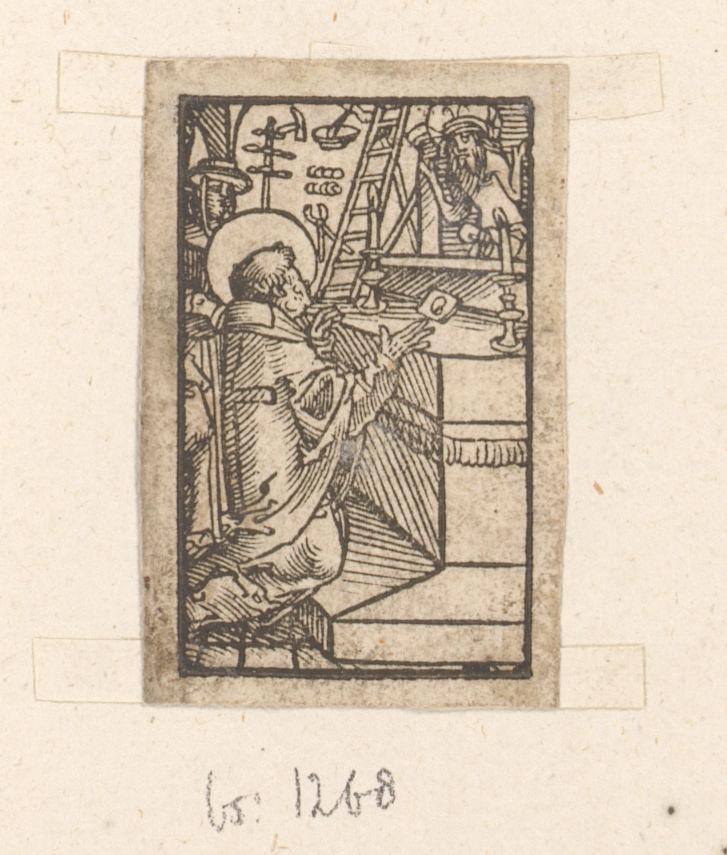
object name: album leaf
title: Mis van Gregorius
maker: Anonymous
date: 1500-1550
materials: paper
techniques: woodcut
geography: germany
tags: the mass of st. gregory the great: christ appears above the altar with the instruments of the passion; maybe blood spouts from christ's side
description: De heilige Gregorius draagt geknield de mis op, terwijl Christus als man van smarten en de passiewerktuigen boven het altaar verschijnen. Prent maakt deel uit van een album.